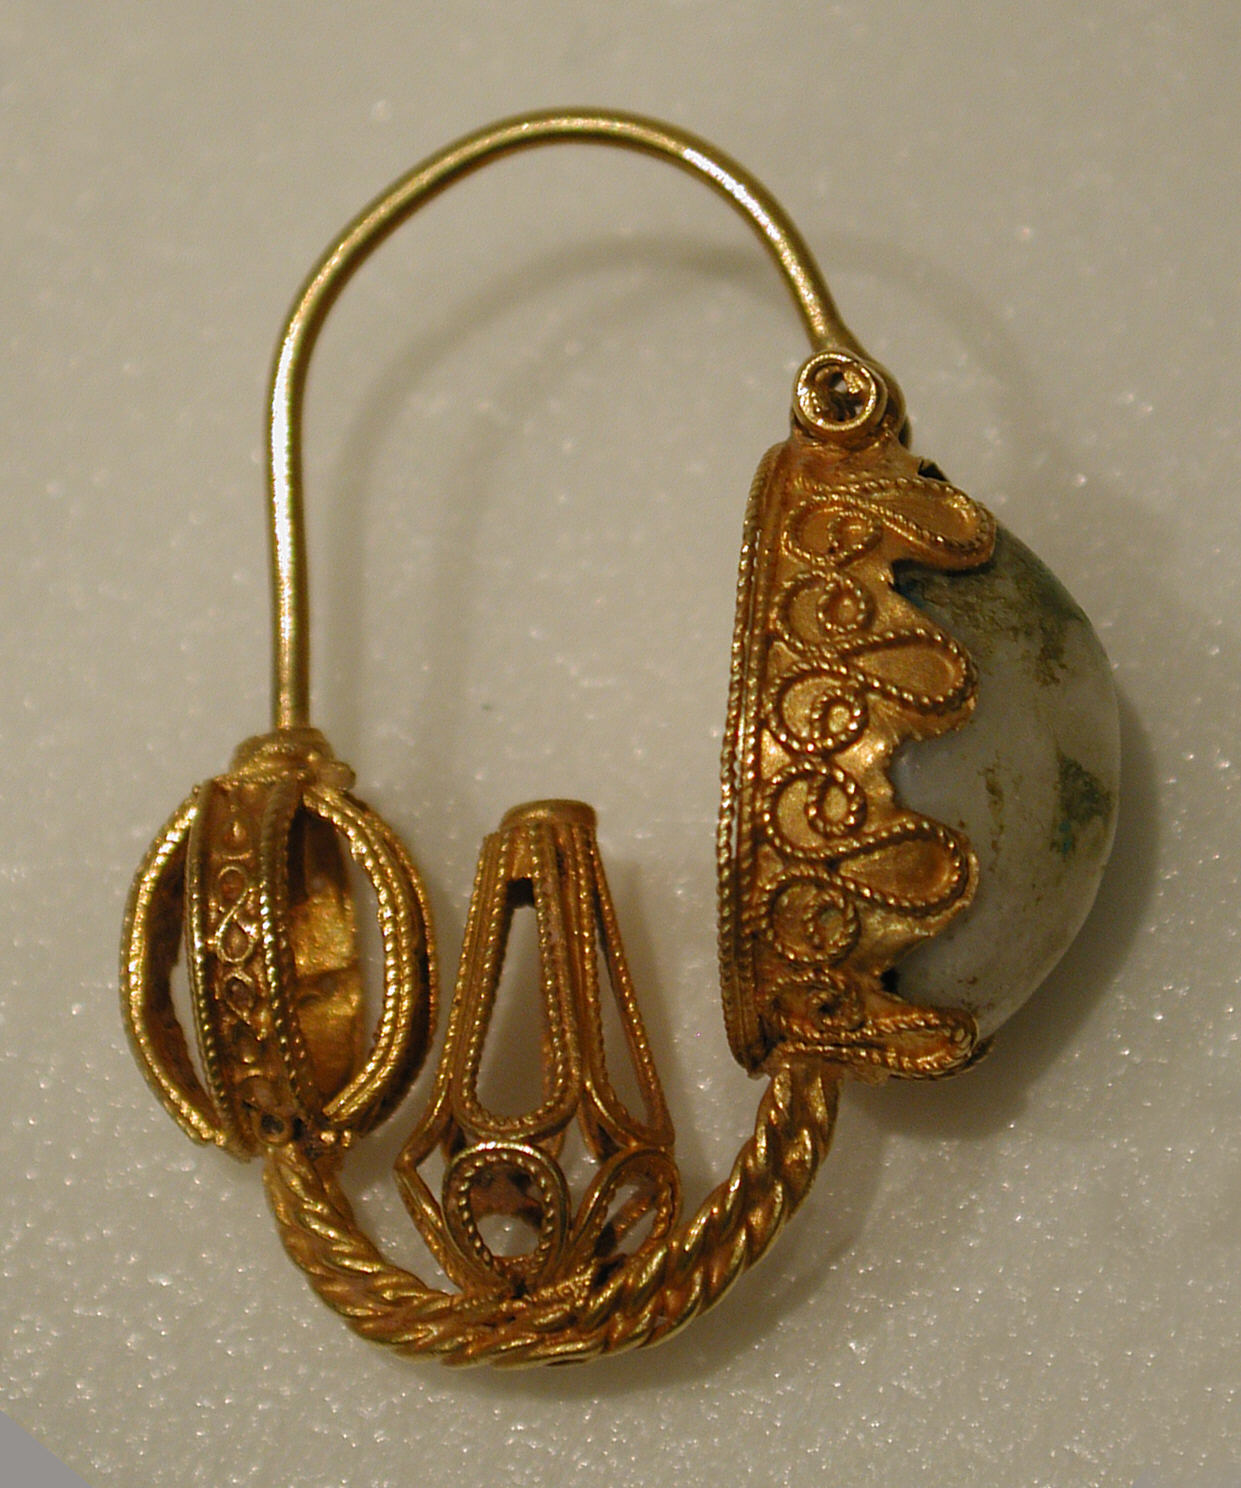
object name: earring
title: Earring, One of a Pair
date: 1101-1200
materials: gold, stone, metal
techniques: filigree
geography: iran